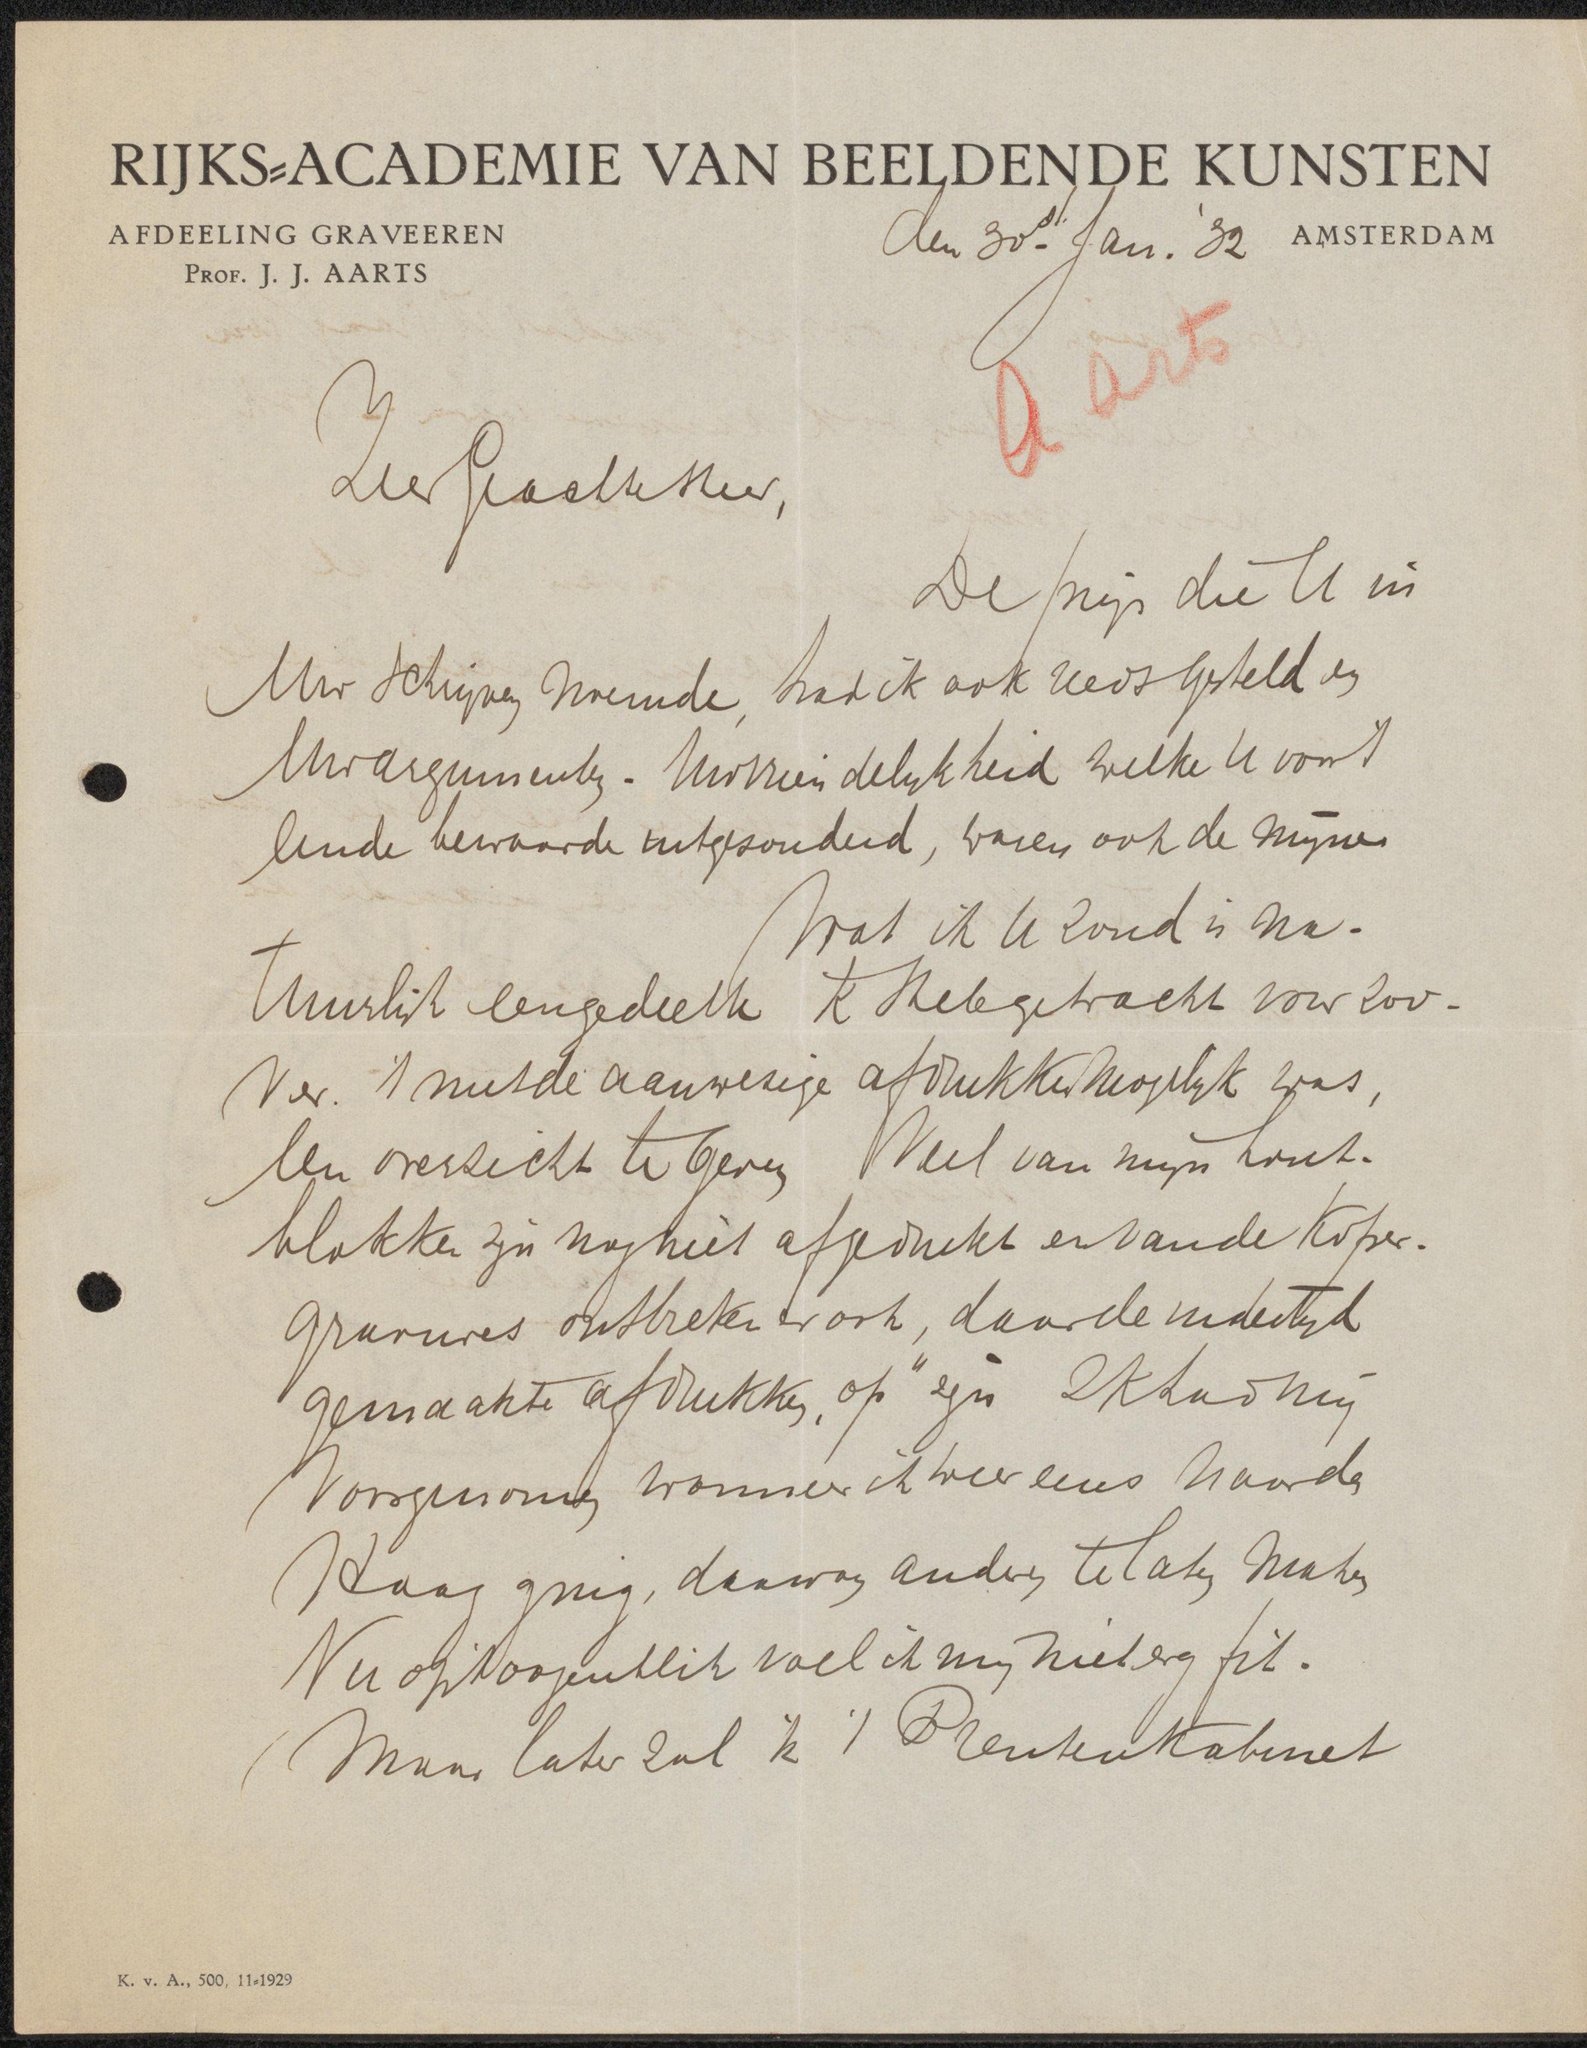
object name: letter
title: Brief aan jonkheer Hendrik Teding van Berkhout (1879-1969)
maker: johannes josephus aarts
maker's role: draughtsman, print maker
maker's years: 1871-1934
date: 1932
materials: ink, paper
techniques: pen, printing, typewriting, writing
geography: amsterdam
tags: print room, haarlem, amsterdam, jonkheer hendrik teding van berkhout (1879-1969), the graphic arts, diseases, art collecting, money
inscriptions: watermark, collector's mark: ‘RPK’